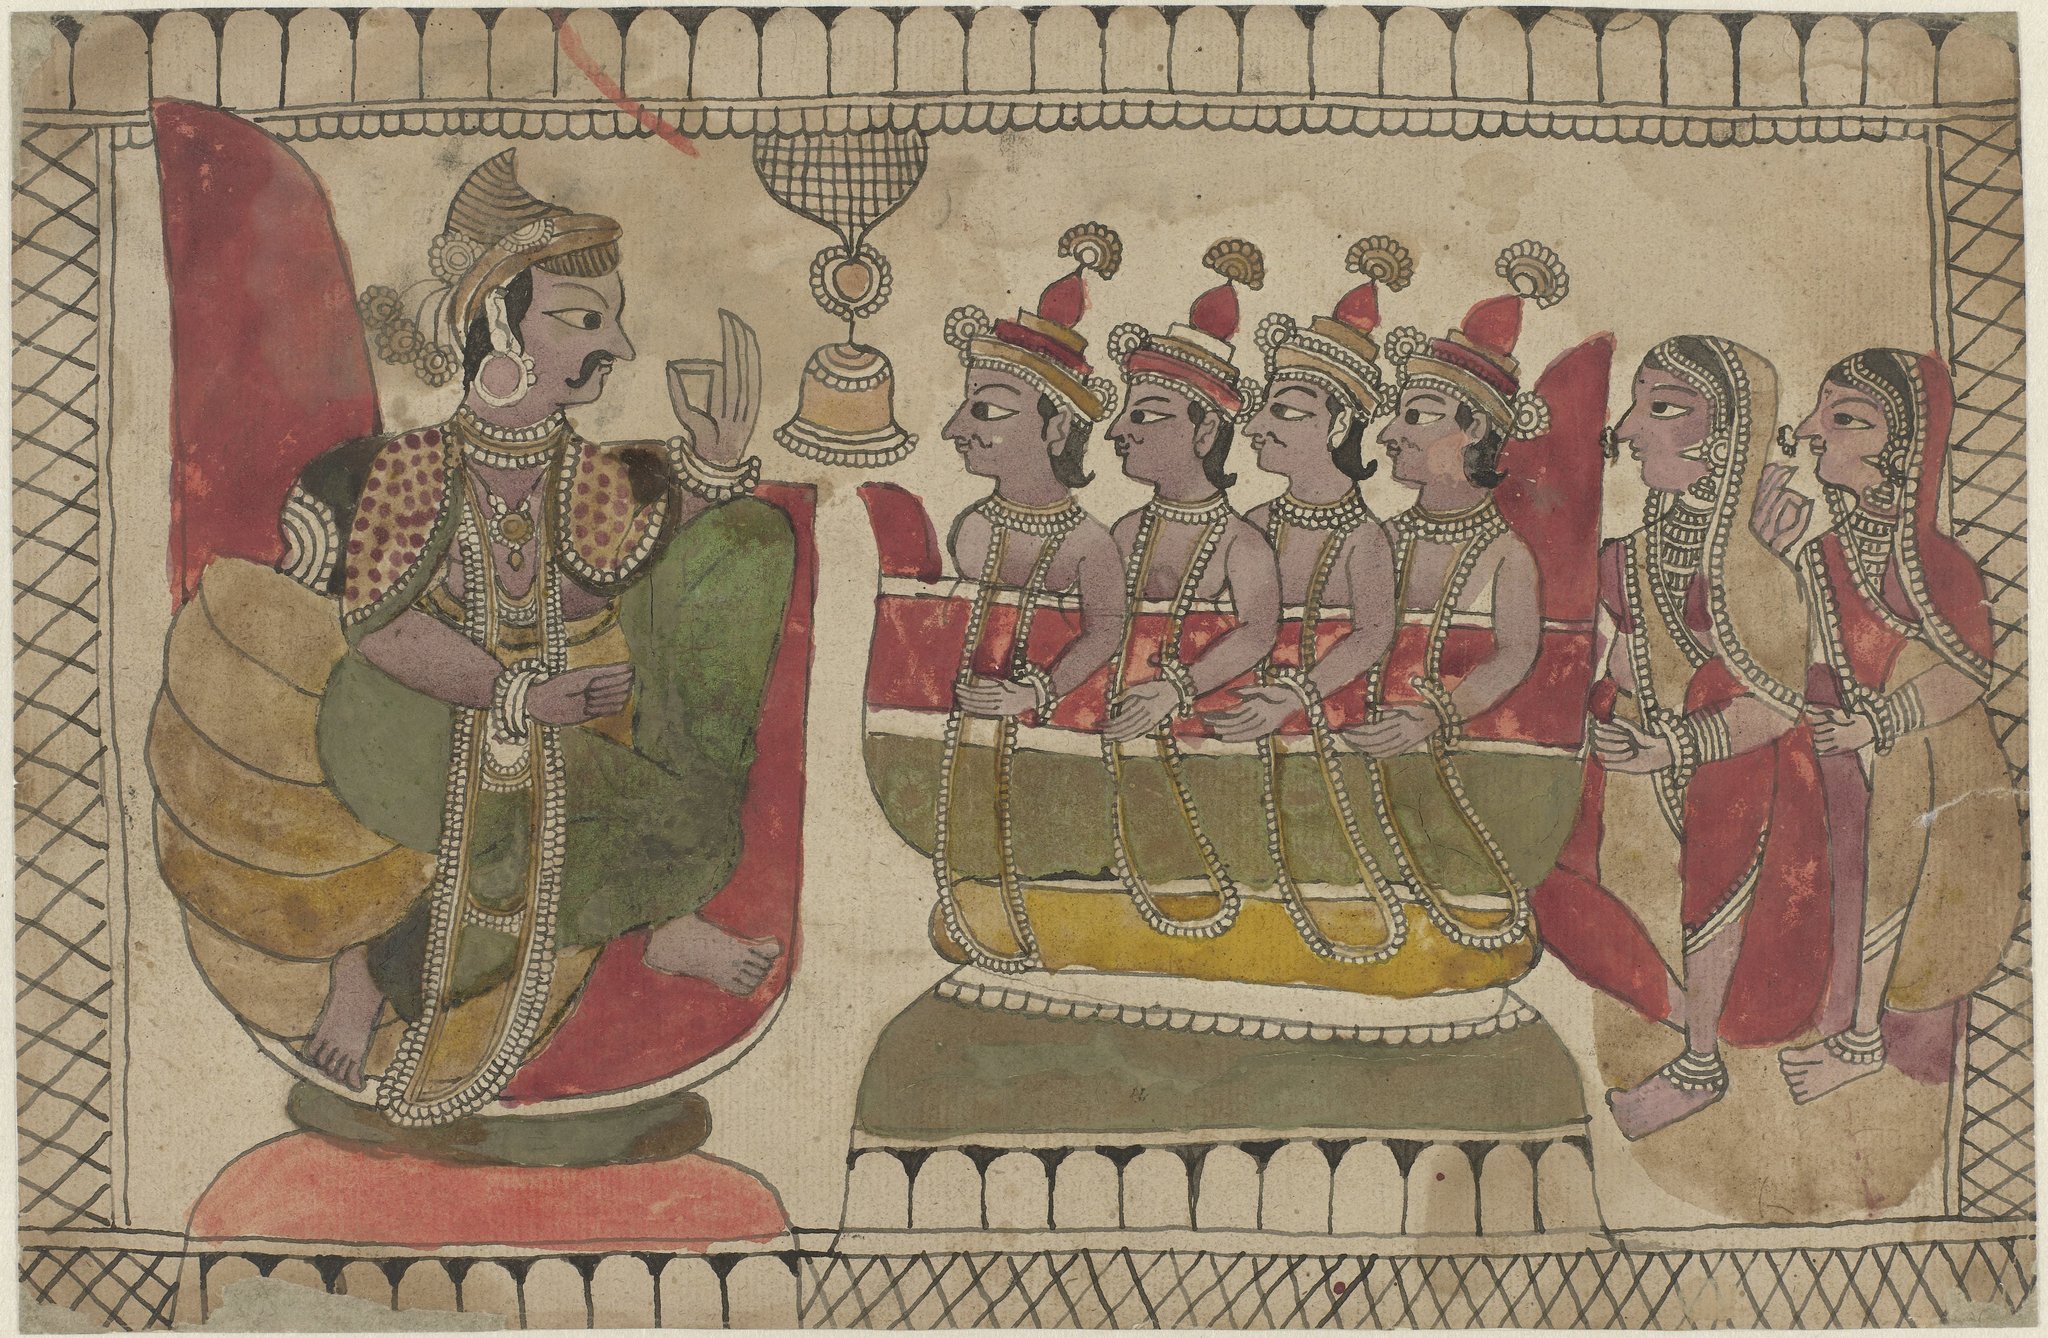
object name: indian miniature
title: Scène uit de Mahabharata of Ramayana (?)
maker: Anonymous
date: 1800-1900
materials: paper, watercolor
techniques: brush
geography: rajasthan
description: Ongeïdentificeerde voorstelling, wellicht een scène uit de Mahabharata of Ramayana.